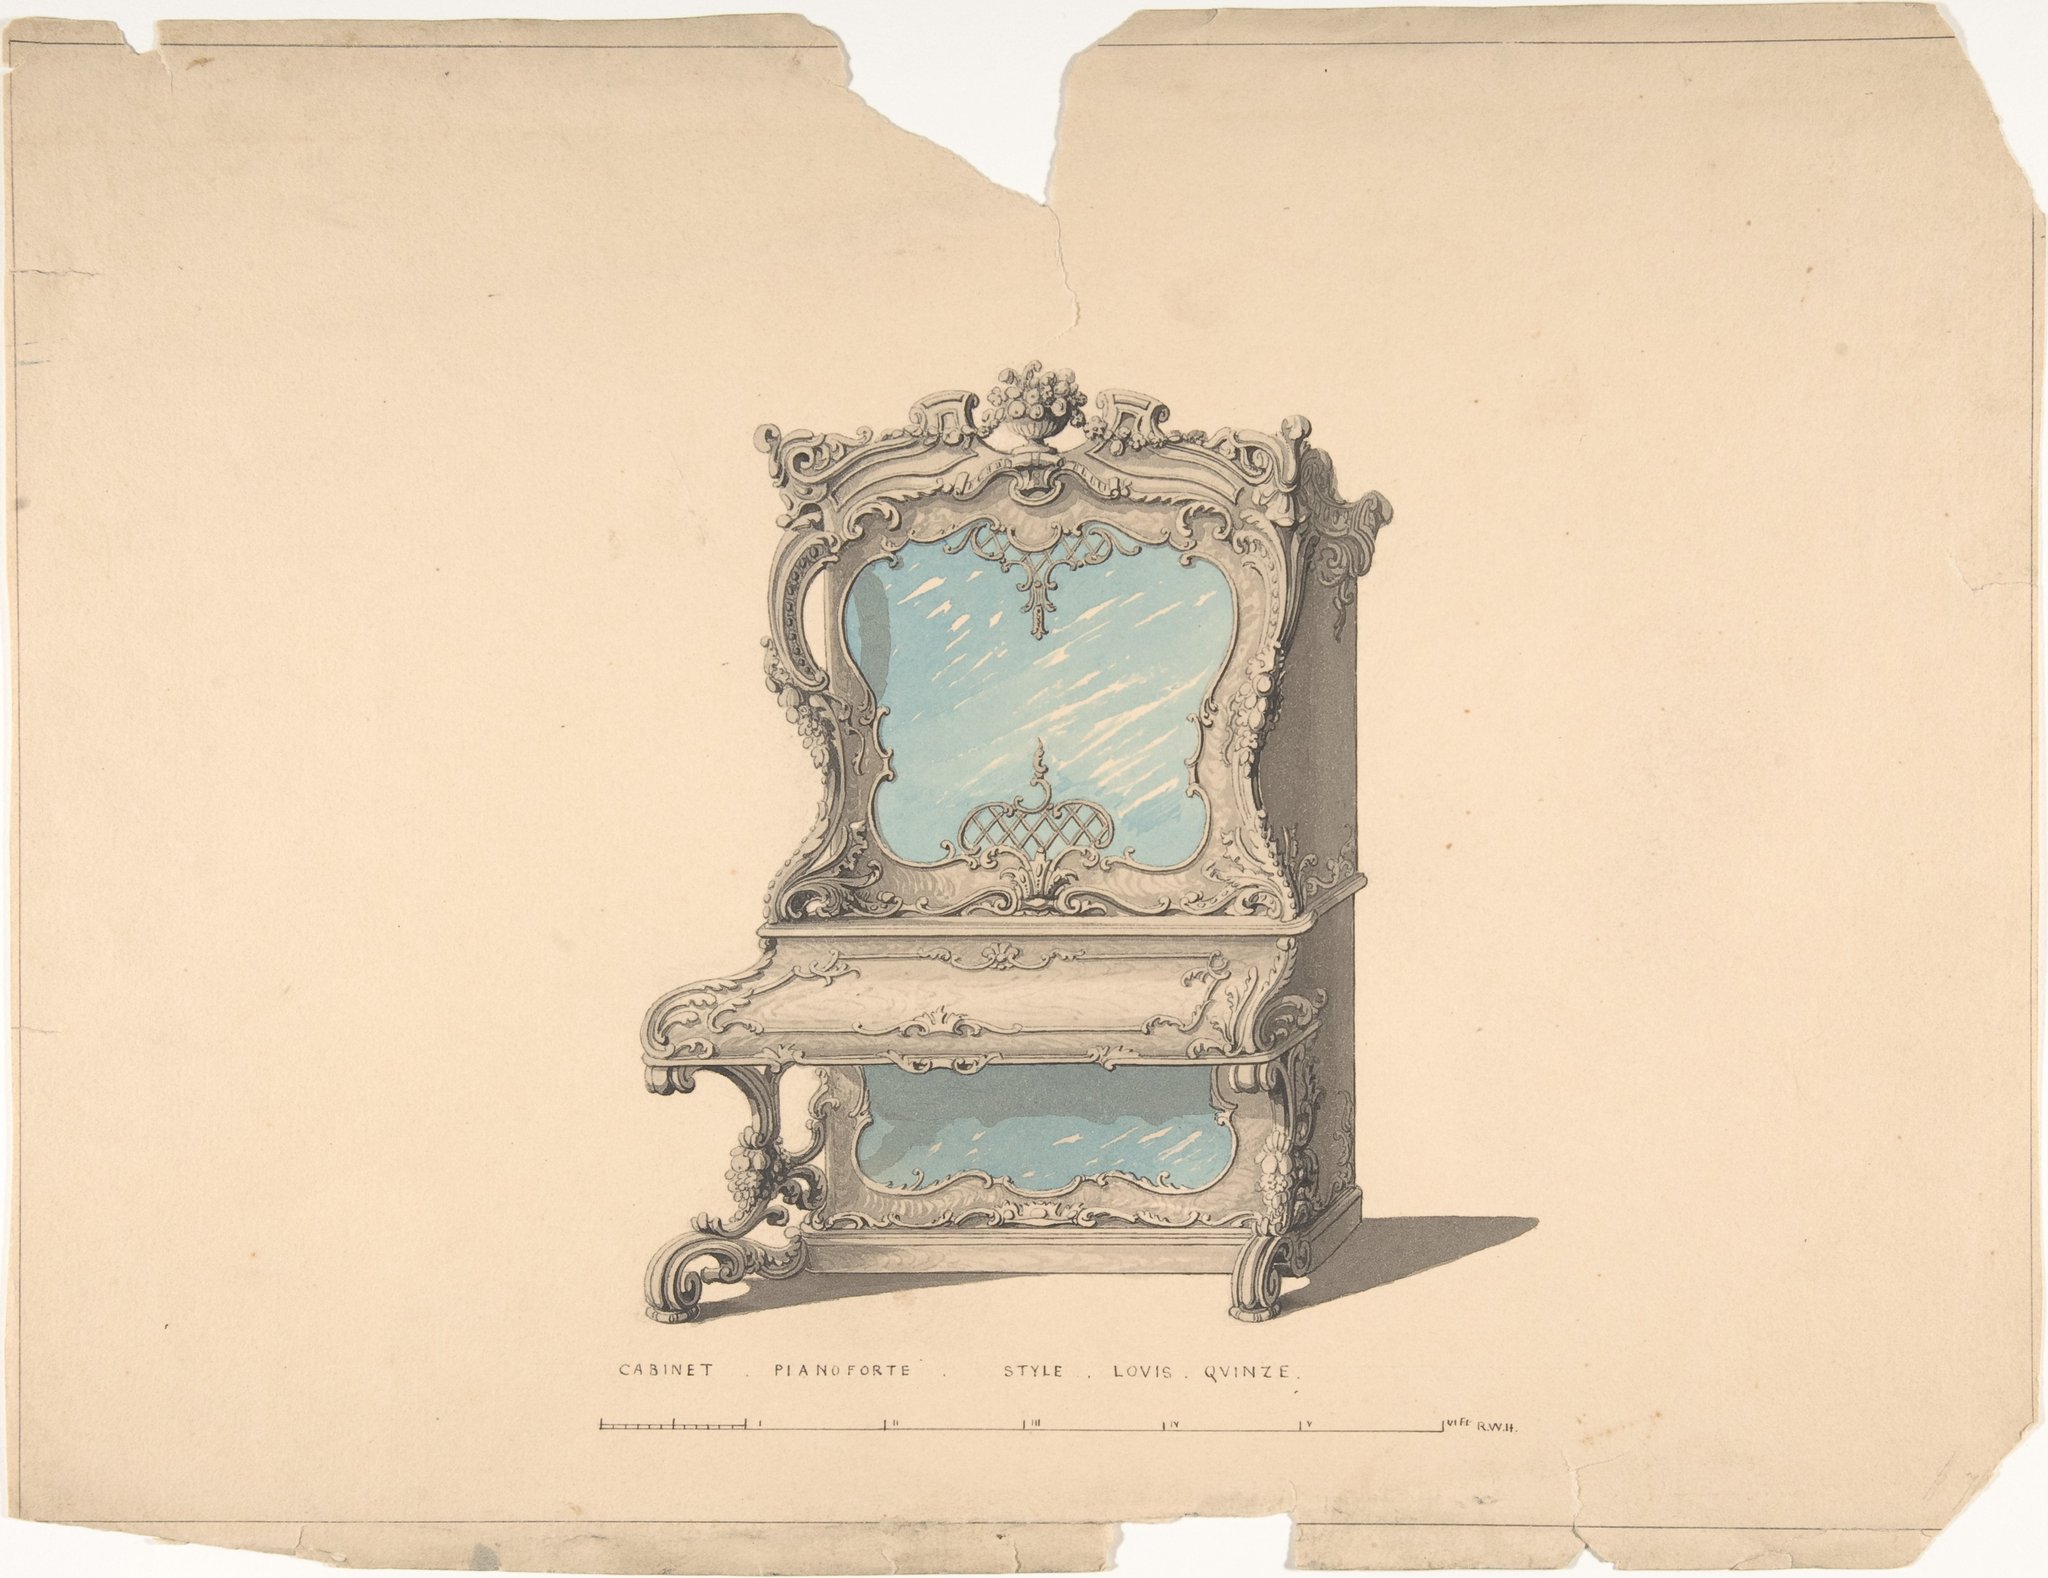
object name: drawing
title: Design for Cabinet Pianoforte, Louis Quinze Style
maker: robert william hume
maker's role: artist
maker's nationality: british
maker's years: 1816-1904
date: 1835-1900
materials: graphite, ink, watercolor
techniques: pen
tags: cabinets,mirrors